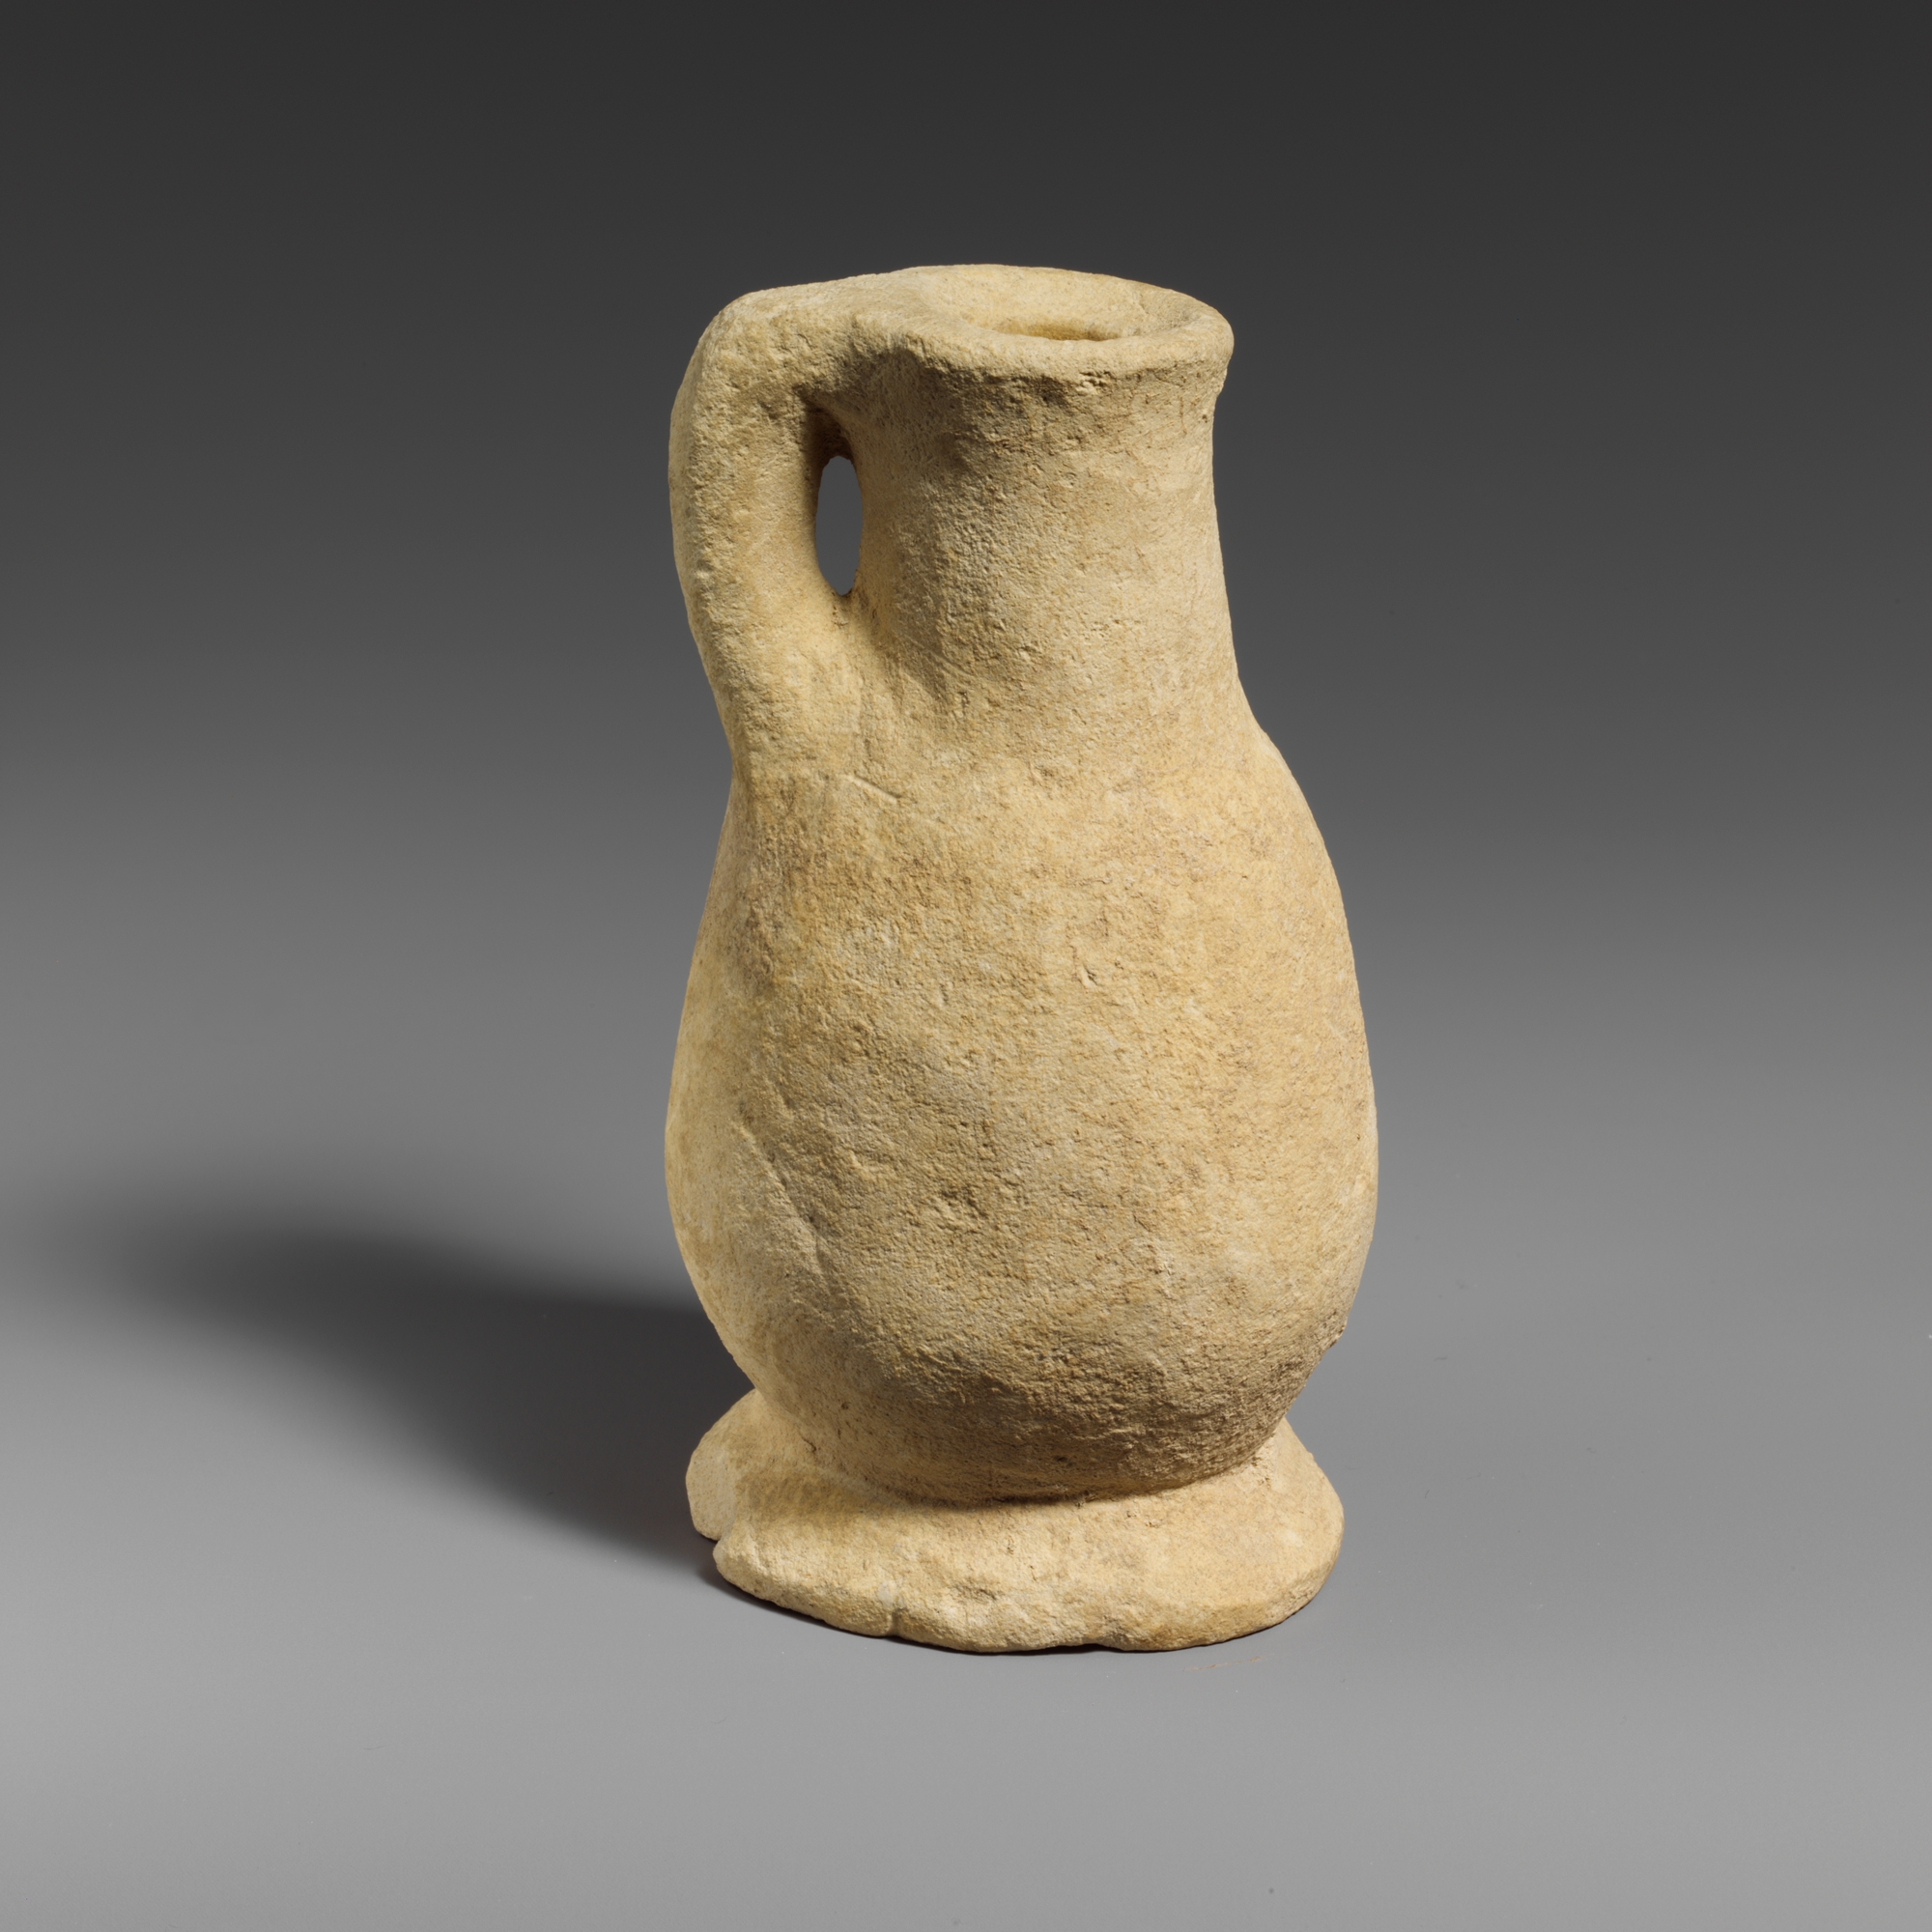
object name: jug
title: Chalk jug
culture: cypriot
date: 500-301 BCE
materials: chalk